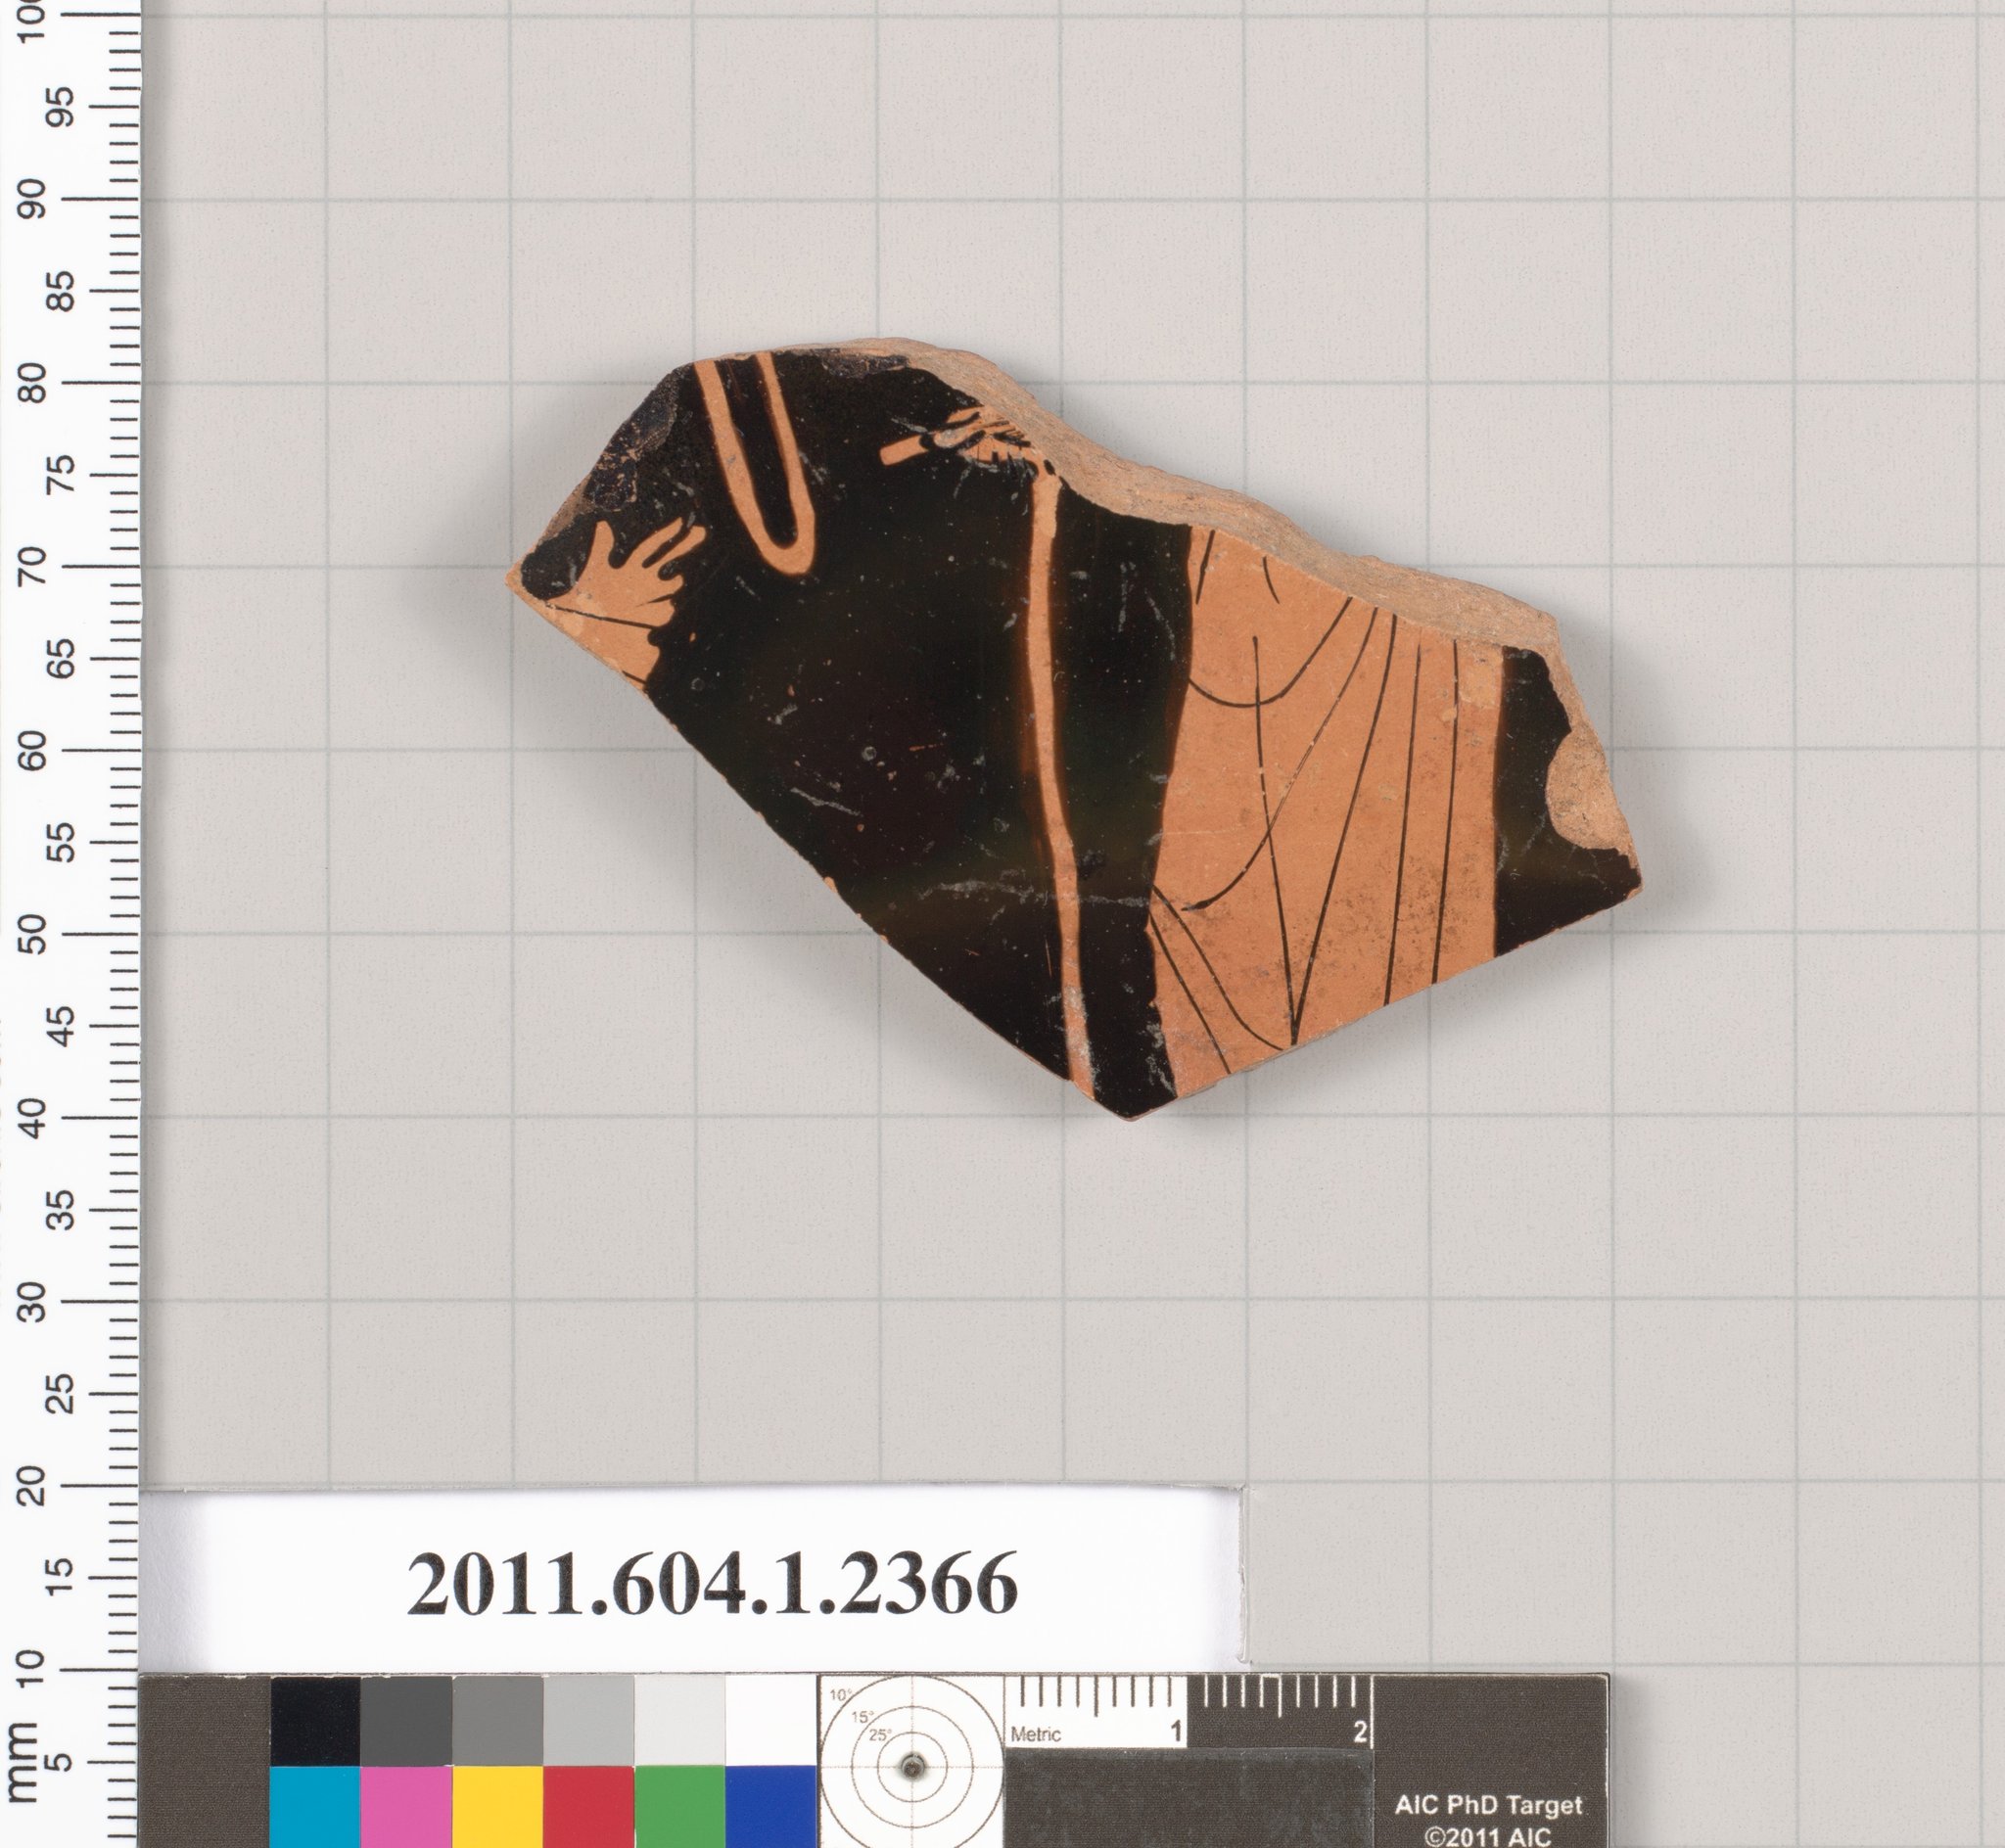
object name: kylix fragment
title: Terracotta fragment of a kylix (drinking cup)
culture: greek, attic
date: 467-435 BCE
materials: terracotta